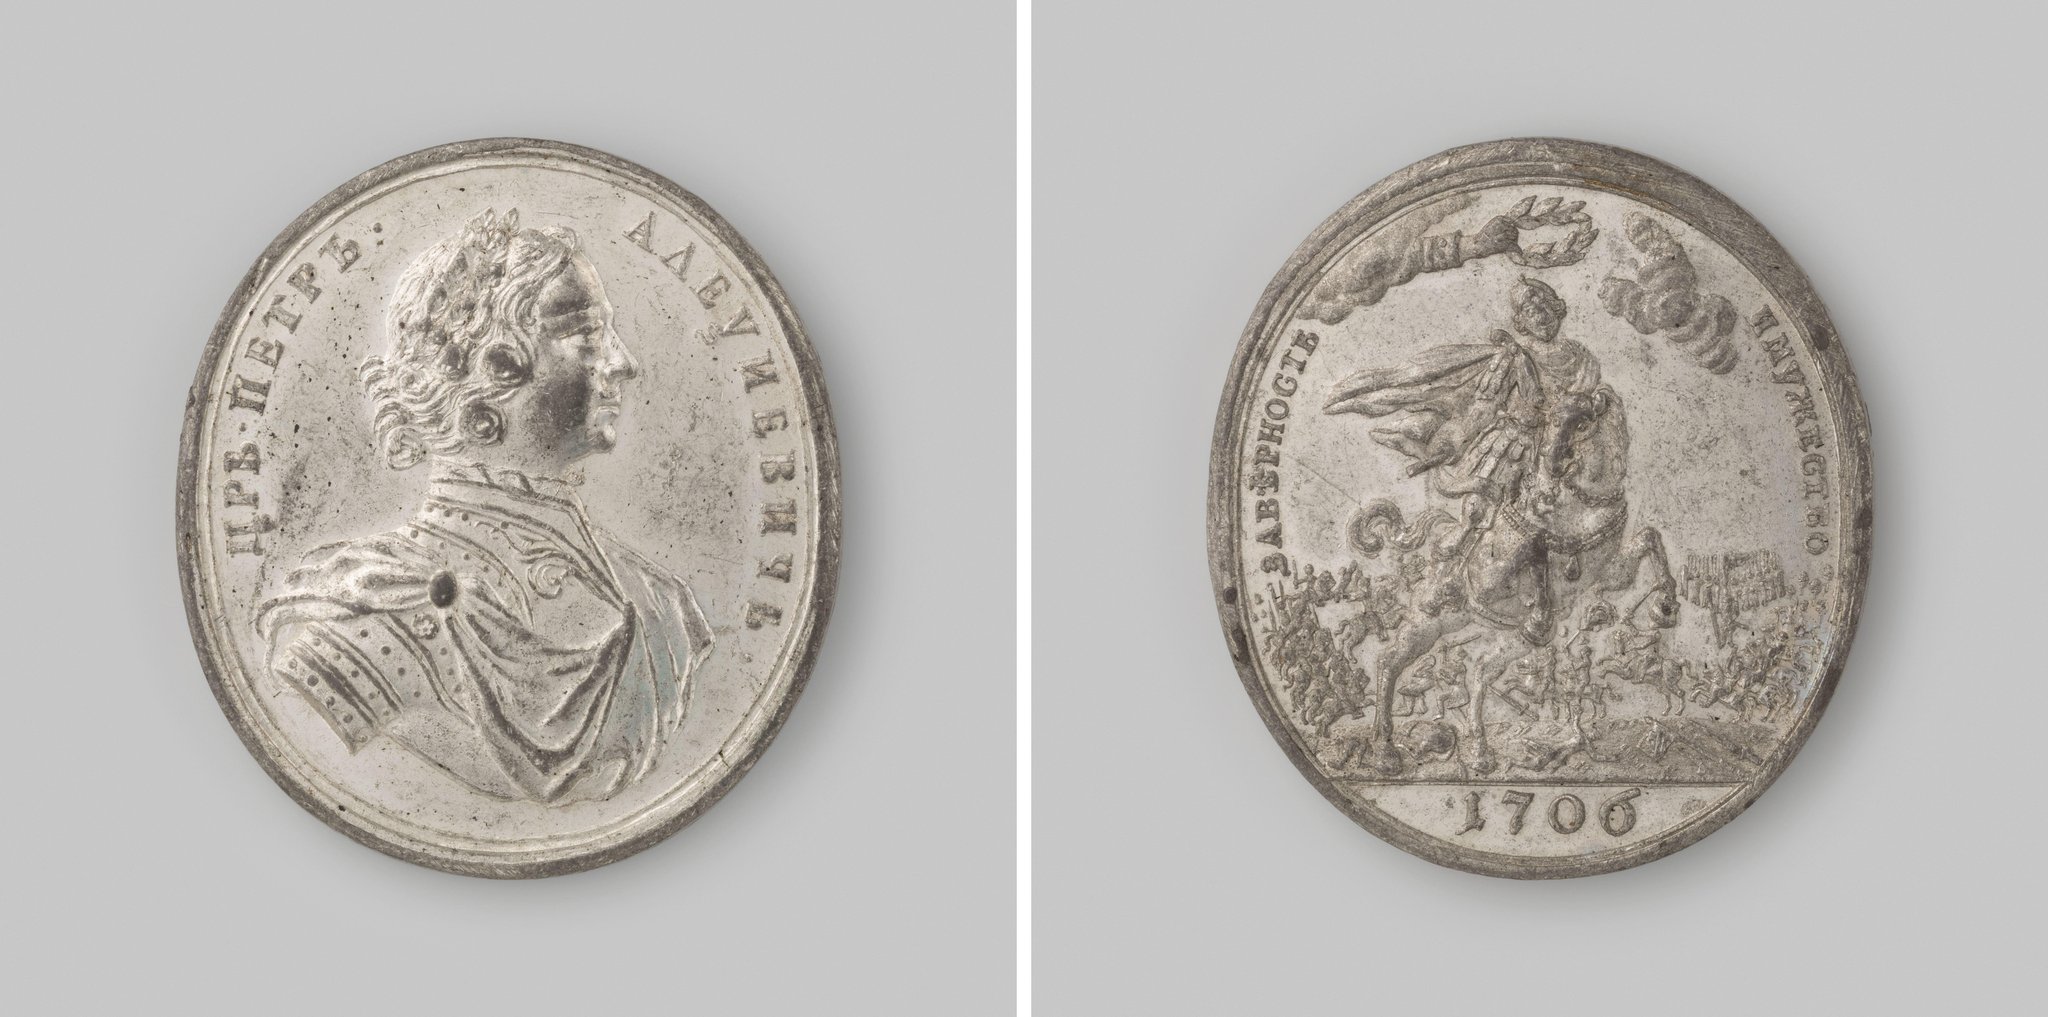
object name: history medal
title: Overwinning van Rusland op Zweden in de slag bij Kalisch 1706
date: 1706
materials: tin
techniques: striking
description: Ovalen tinnen penning, op de voorzijde het borstbeeld van Tsaar Peter de Grote naar rechts met omschrift, op de keerzijde de Tsaar te paard half naar rechts onder de hand Gods met lauwerkrans, op de achtergrond vechtende soldaten, met omschrift en afsnedetekst.